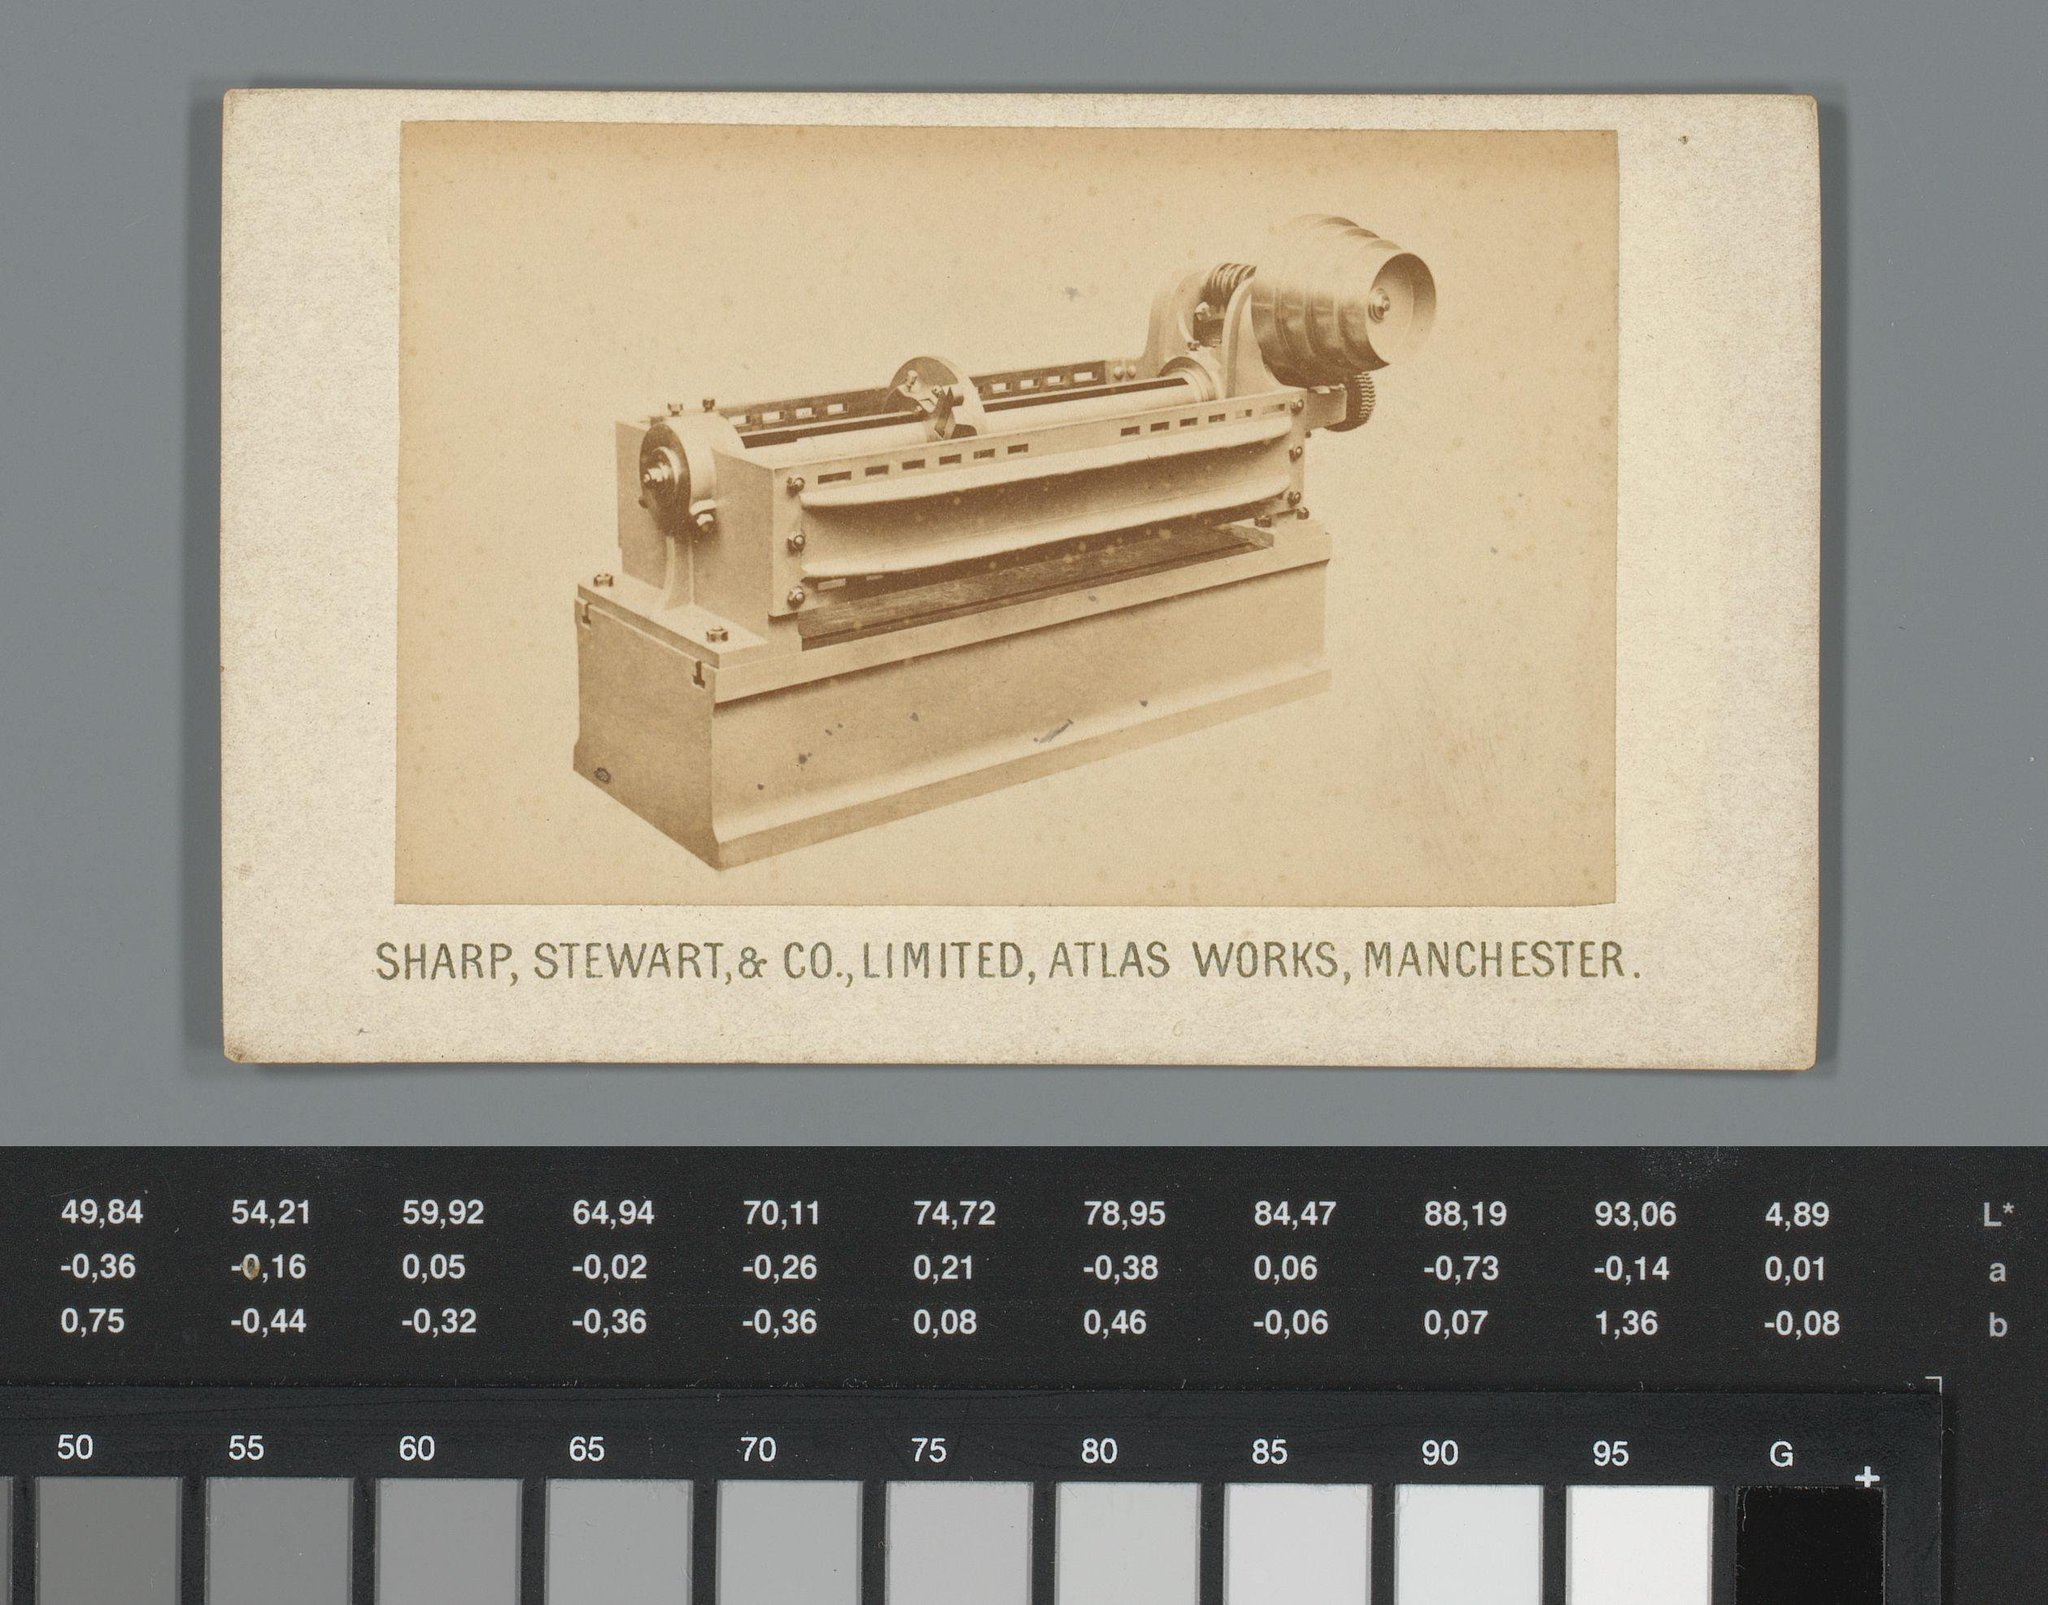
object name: photograph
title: Reclame voor een machine van Sharp, Stewart & Co. uit Manchester, Engeland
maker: Anonymous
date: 1852-1903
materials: cardboard, photographic support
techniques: albumen print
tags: advertising, machines; parts of machines; tools and appliances, manchester